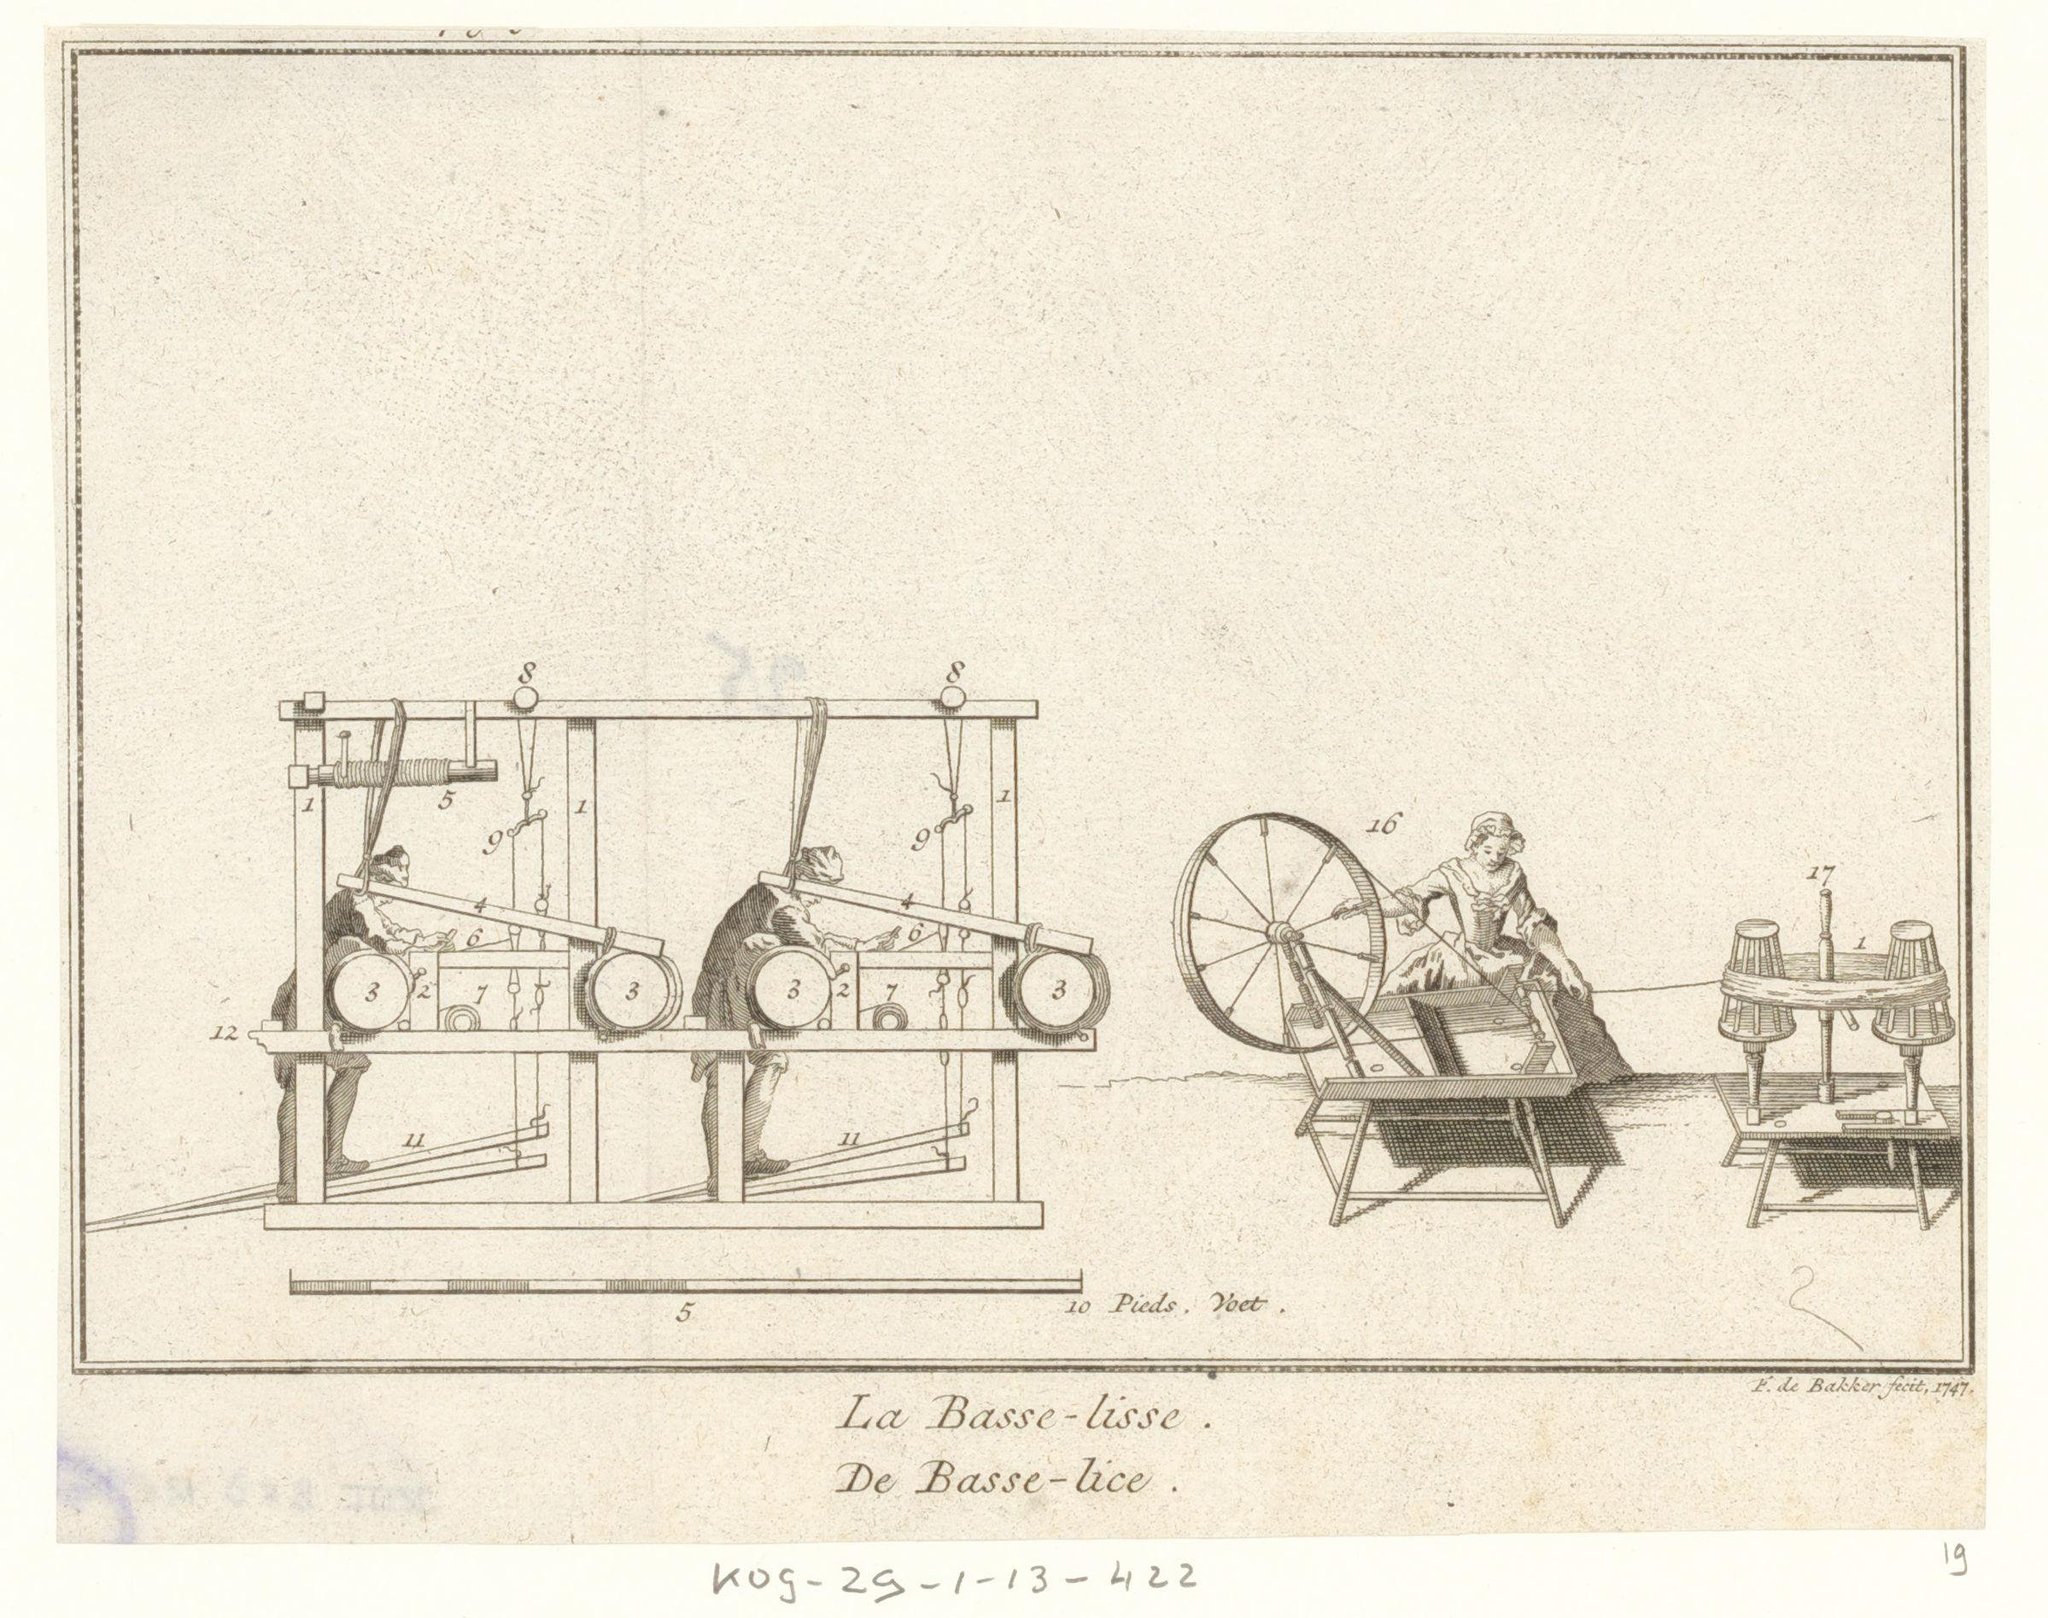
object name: print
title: Weefgetouw voor de Basse-lisse methode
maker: frans de bakker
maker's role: print maker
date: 1747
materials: paper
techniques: engraving, etching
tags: tapestry weaver, gobelin maker, textile industry and clothing industry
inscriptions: collector's mark: Lugt 1641, stamp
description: Prent mogelijk uit: Noël-Antoine Pluche. Schouwtoneel der natuur, of Samenspraaken over de Bysonderheden der natuurlyke histori (...). [Vertaald uit het Frans door] Pieter le Clercq. 14 dln. Amsterdam: Salomon Schouten, 1737-1749, dl. 12, na p. 318.